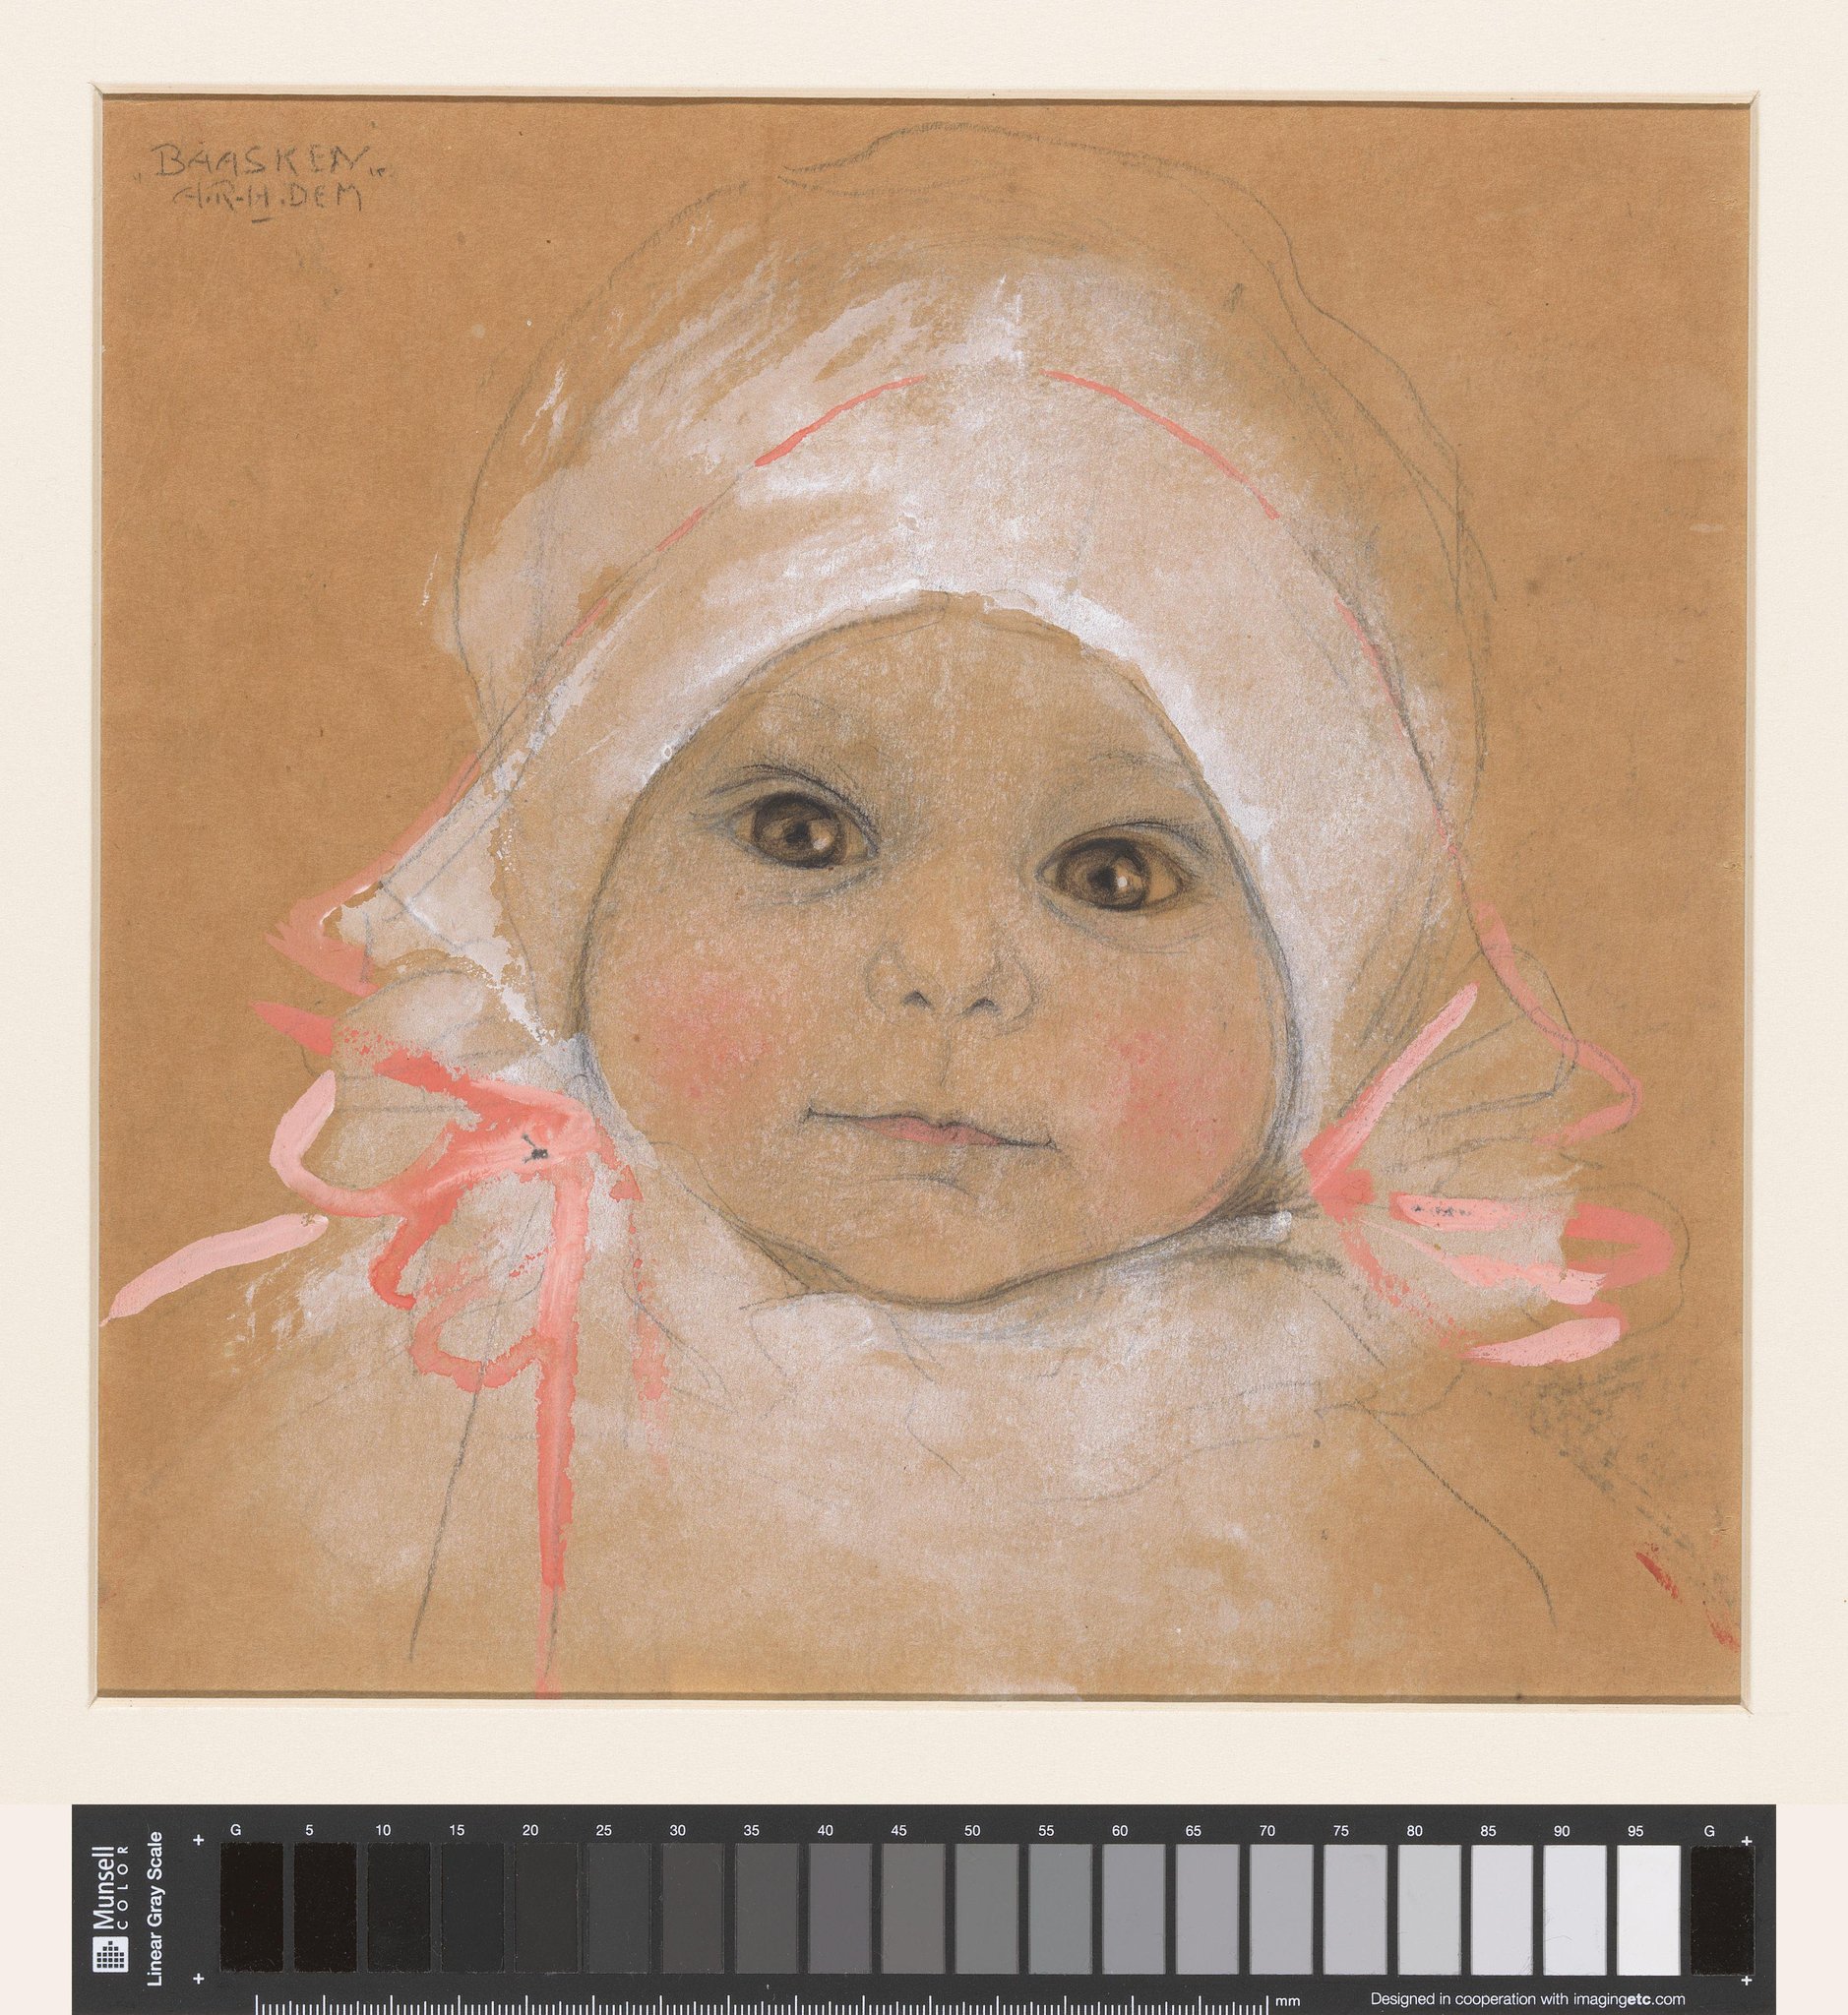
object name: drawing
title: Baasken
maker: annie roland holst-de meester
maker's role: draughtsman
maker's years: 1893-1987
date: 1917-1922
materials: chalk, gouache, paper, pencil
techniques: brush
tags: historical persons, child (at home)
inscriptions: collector's mark: Lugt 2228